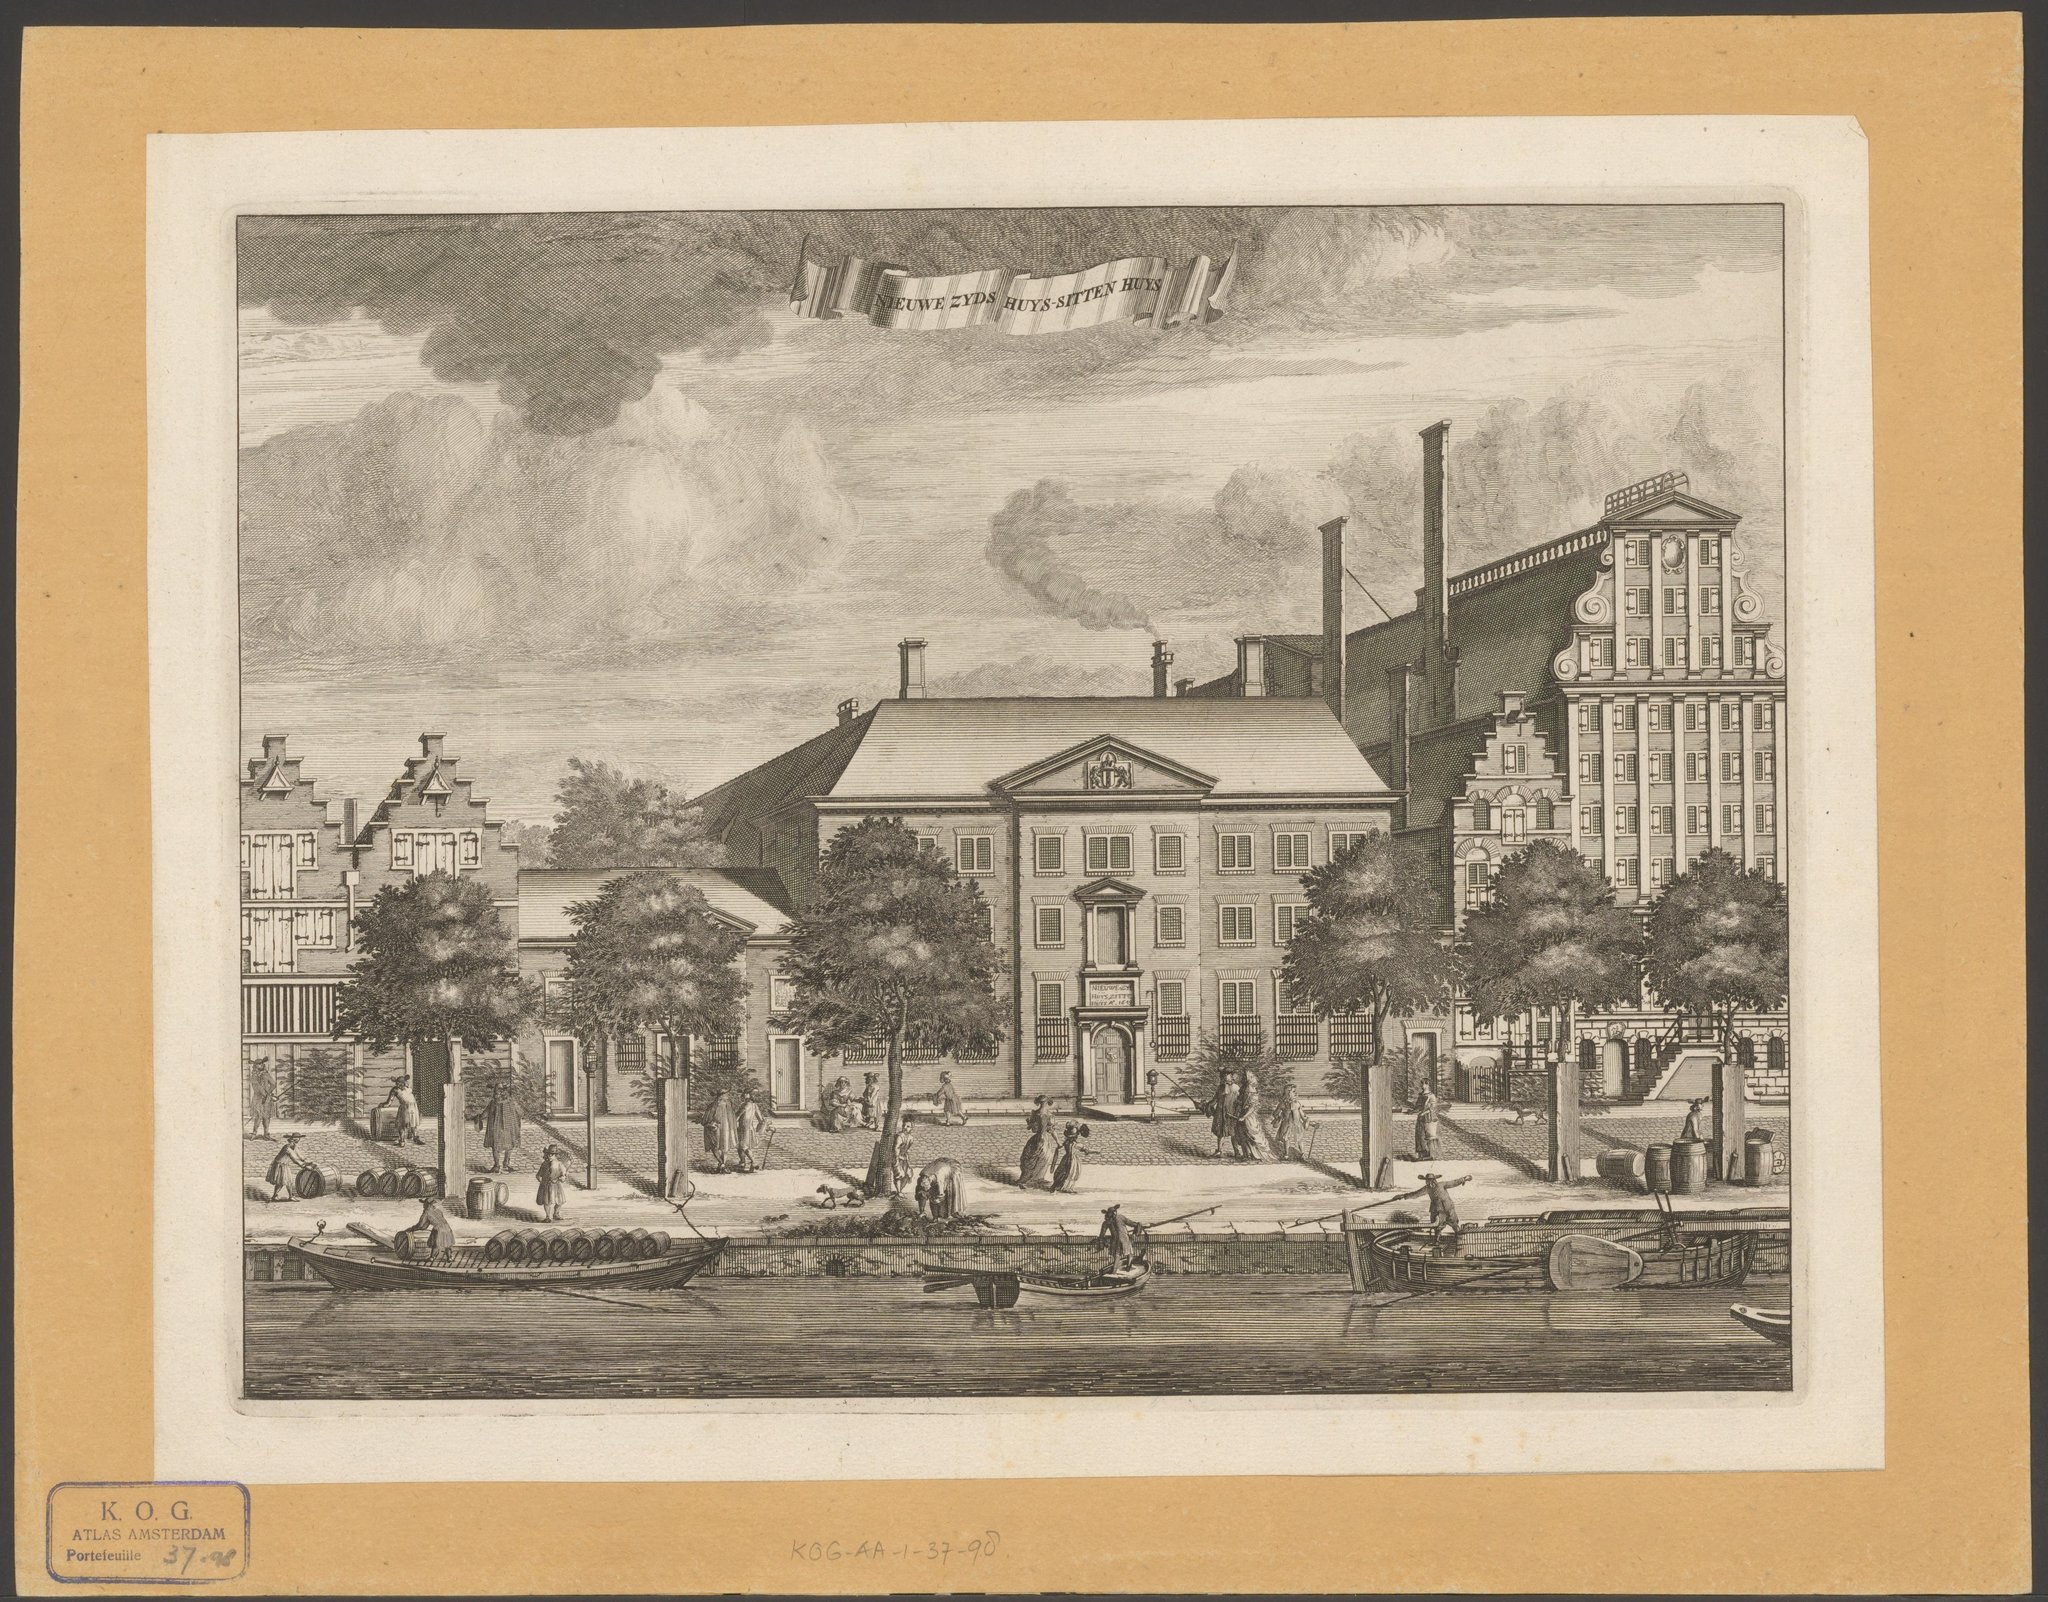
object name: print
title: Gezicht op het Nieuwezijds Huiszittenhuis te Amsterdam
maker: Anonymous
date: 1726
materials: paper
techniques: engraving, etching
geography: northern netherlands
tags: poorhouse, canals, waters (in city) (+ city(-scape) with figures, staffage)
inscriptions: collector's mark: Lugt 1641b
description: Huidige staat van prent ook gebruikt in: Commelin, Casparus. Beschryvinge van Amsterdam (…). 2de druk. Amsterdam: Andries van Damme, Johannes Ratelband, weduwe Antony van Aeltwijk en Hermanus Uytwerf, 1726, dl. 2. Eerste staat van prent (zonder opgewerkte lucht- en waterpartijen) ook gebruikt in: Commelin, Casparus. Beschryvinge van Amsterdam (…). Amsterdam: Abraham Wolfgang, Gillis Janssonius van Waesberge of Johannes Janssonius van Waesberge, Hendrick Boom of weduwe Dirk Boom, Abraham van Sanderen en Rembertus Goethals, 1693, dl. 2. En in: Commelin, Casparus. Beschryvinge van Amsterdam (…). Amsterdam: weduwe Aart Dircksz. Oossaan, 1694, dl. 2.